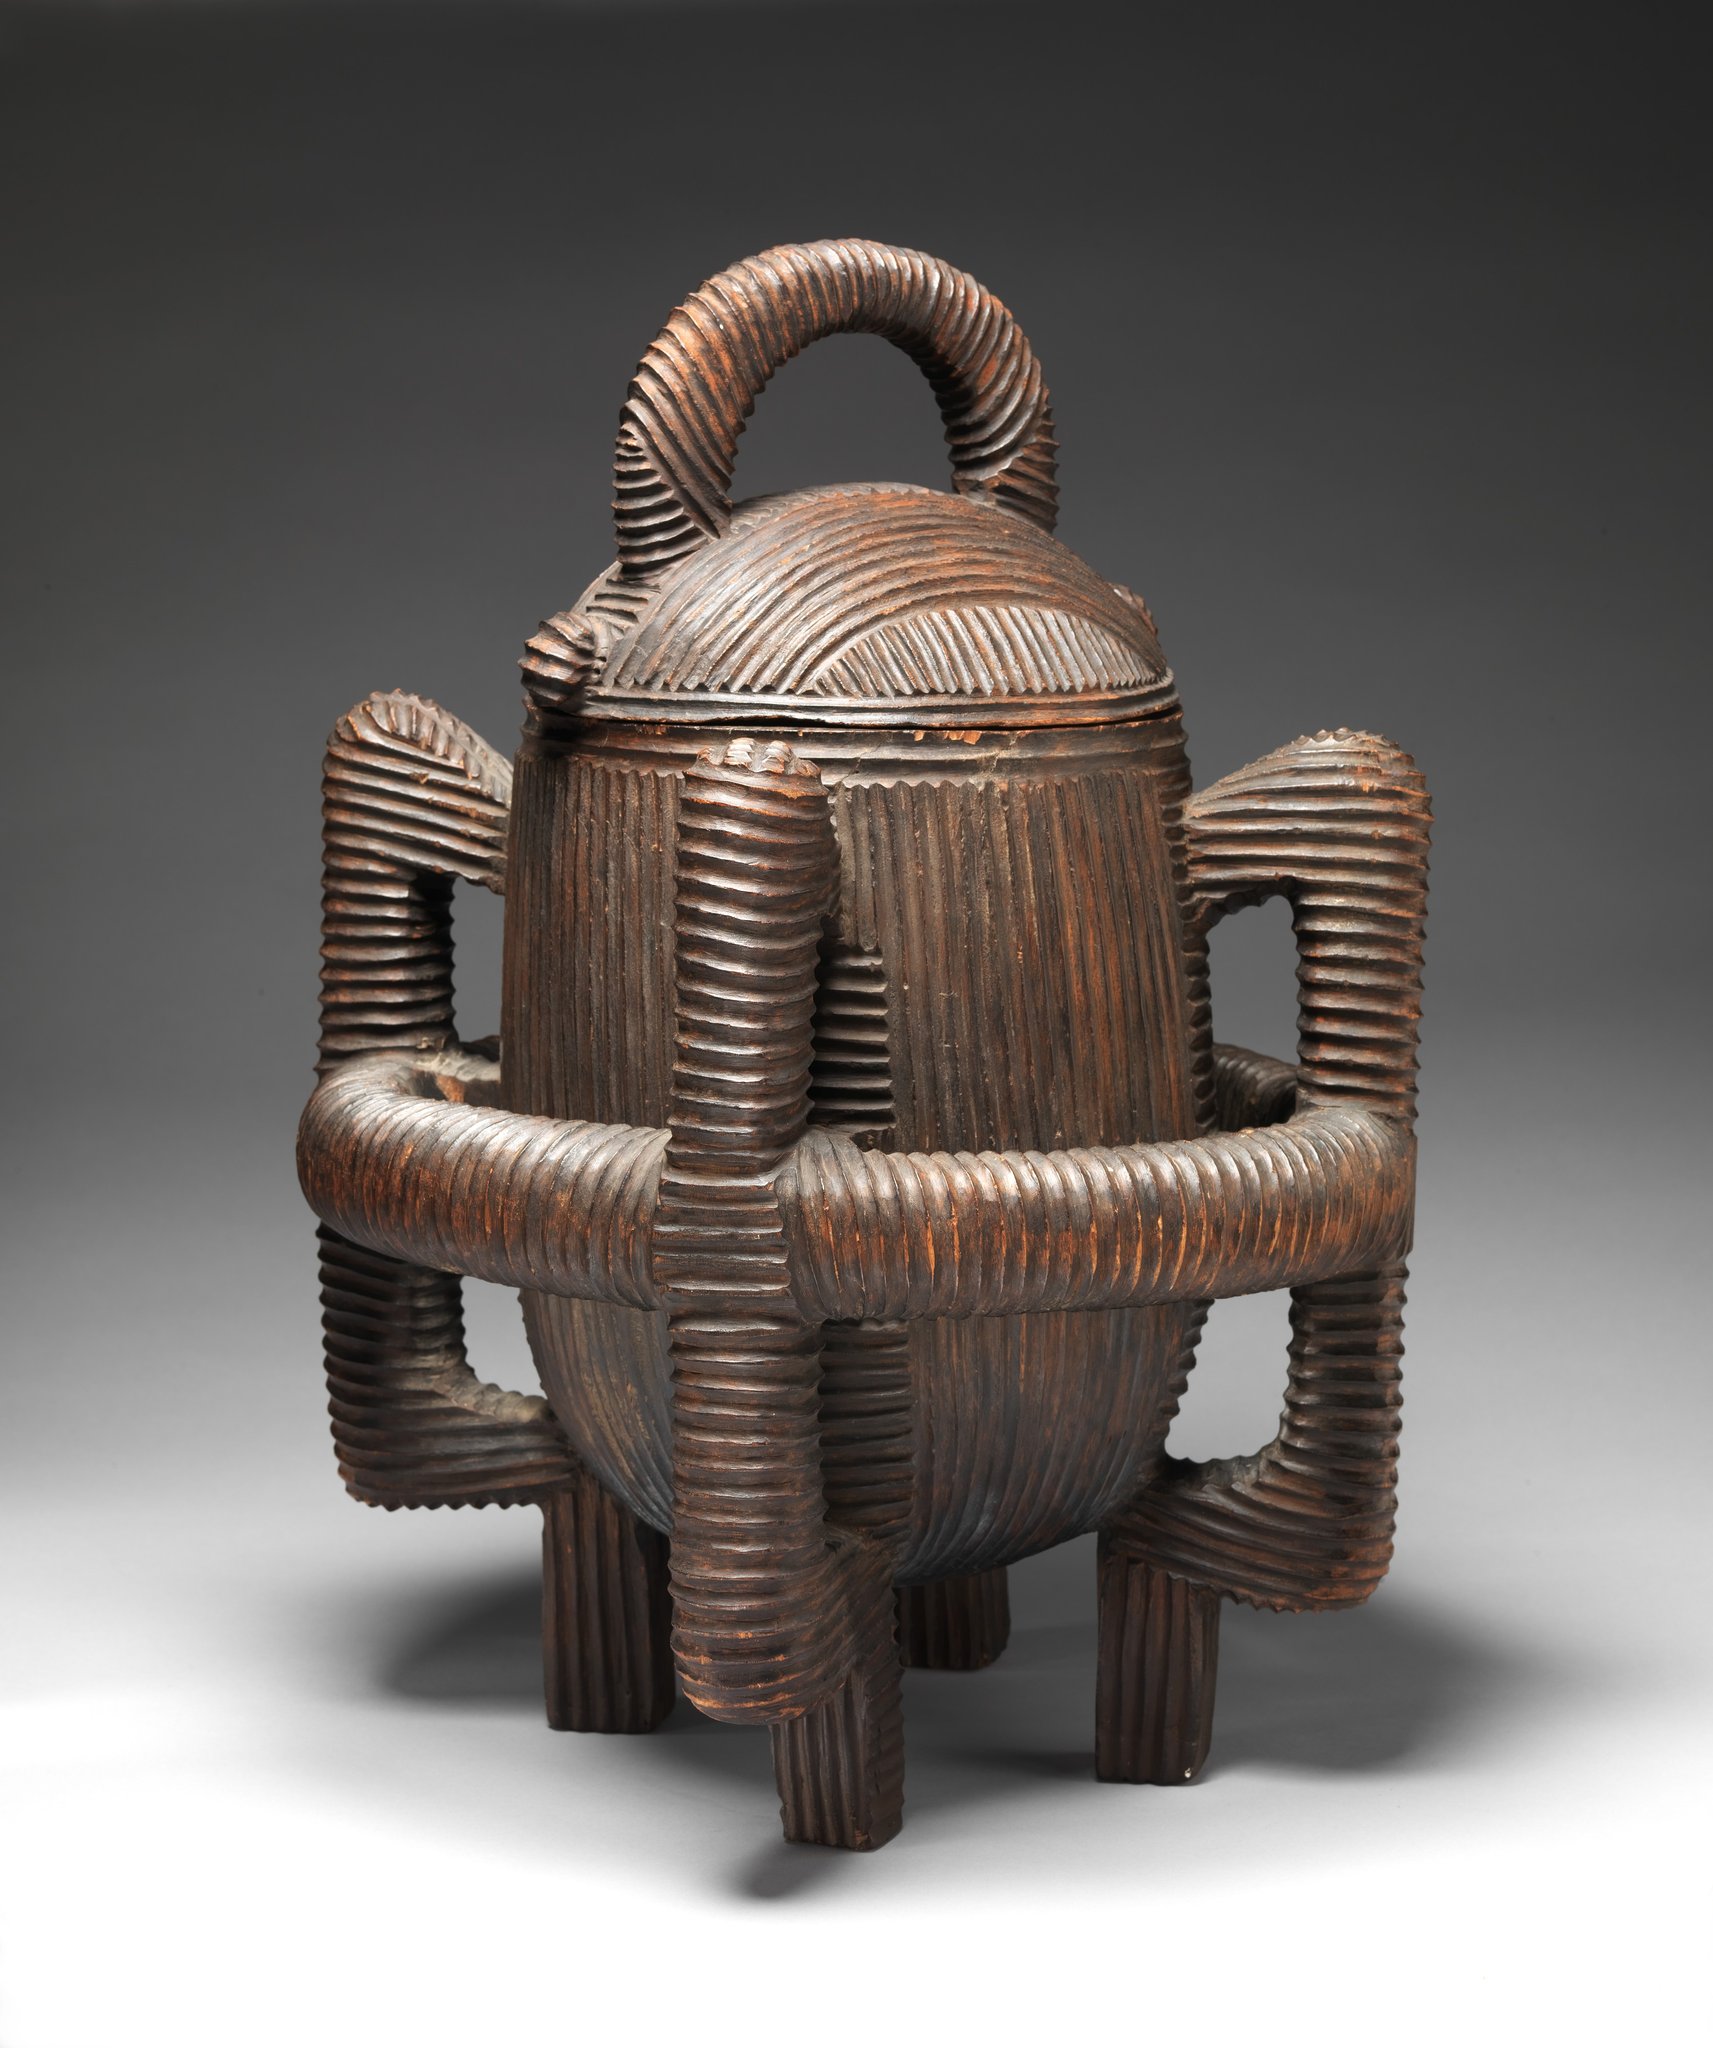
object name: vessel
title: Lidded prestige vessel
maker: circle of "unobadula"(?)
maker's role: artist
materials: wood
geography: south africa